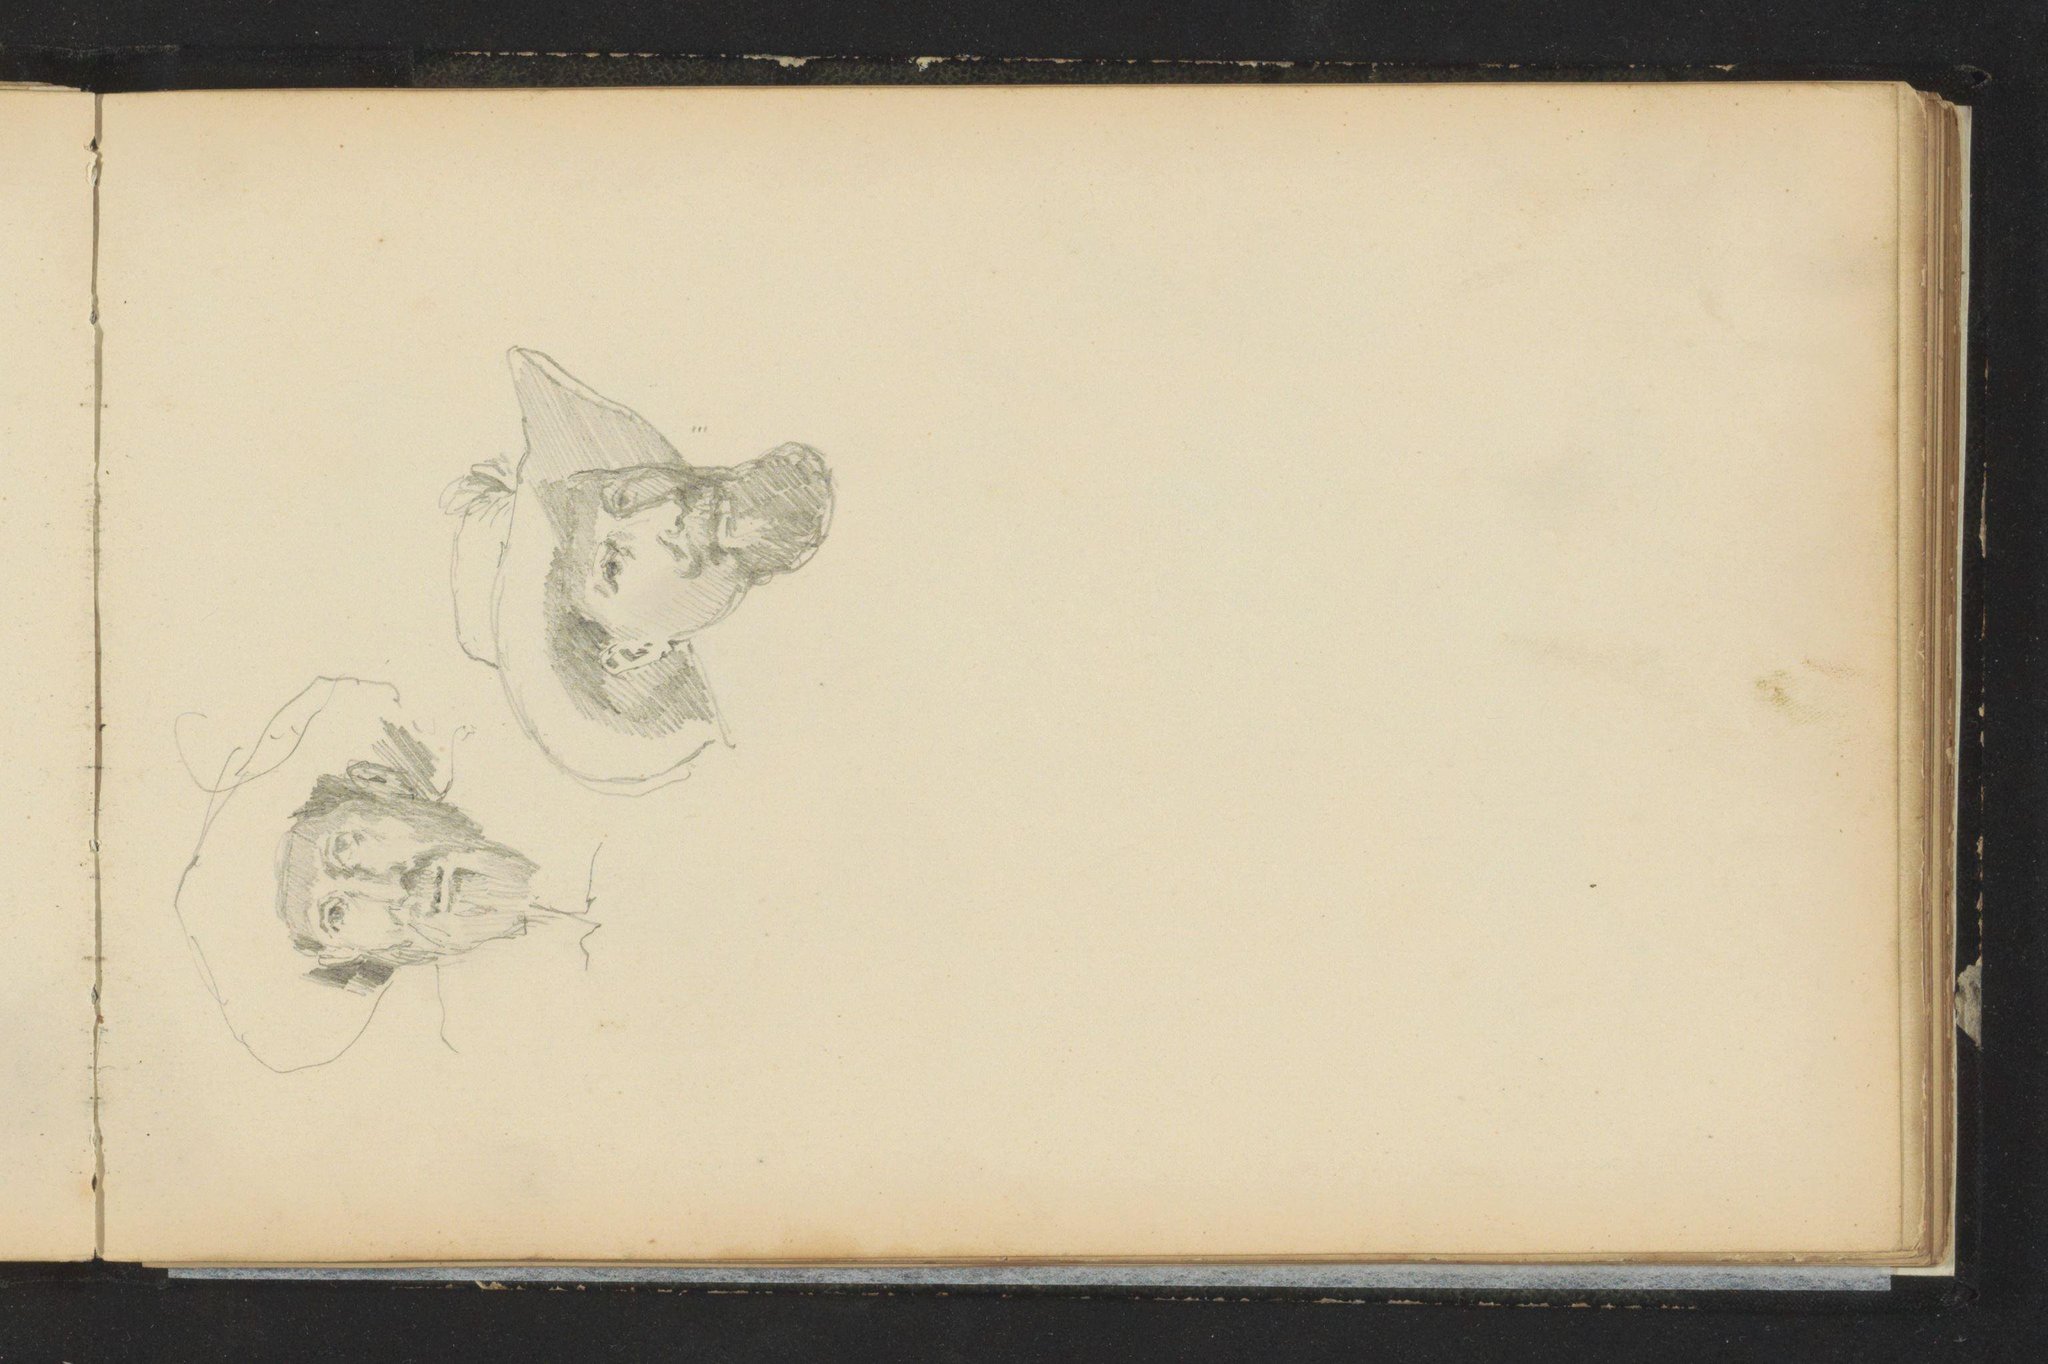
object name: sketchbook leaf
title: Twee mannenhoofden met hoeden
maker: cornelis springer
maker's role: draughtsman, painter, print maker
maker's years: 1817-1891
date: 1846-1882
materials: paper, pencil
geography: netherlands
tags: head (human), head-gear: hat (+ men's clothes), clothes, costume (+ men's clothes)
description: Twee bebaarde mannenhoofden met hoeden. Blad 51 uit een schetsboek met 91 bladen.